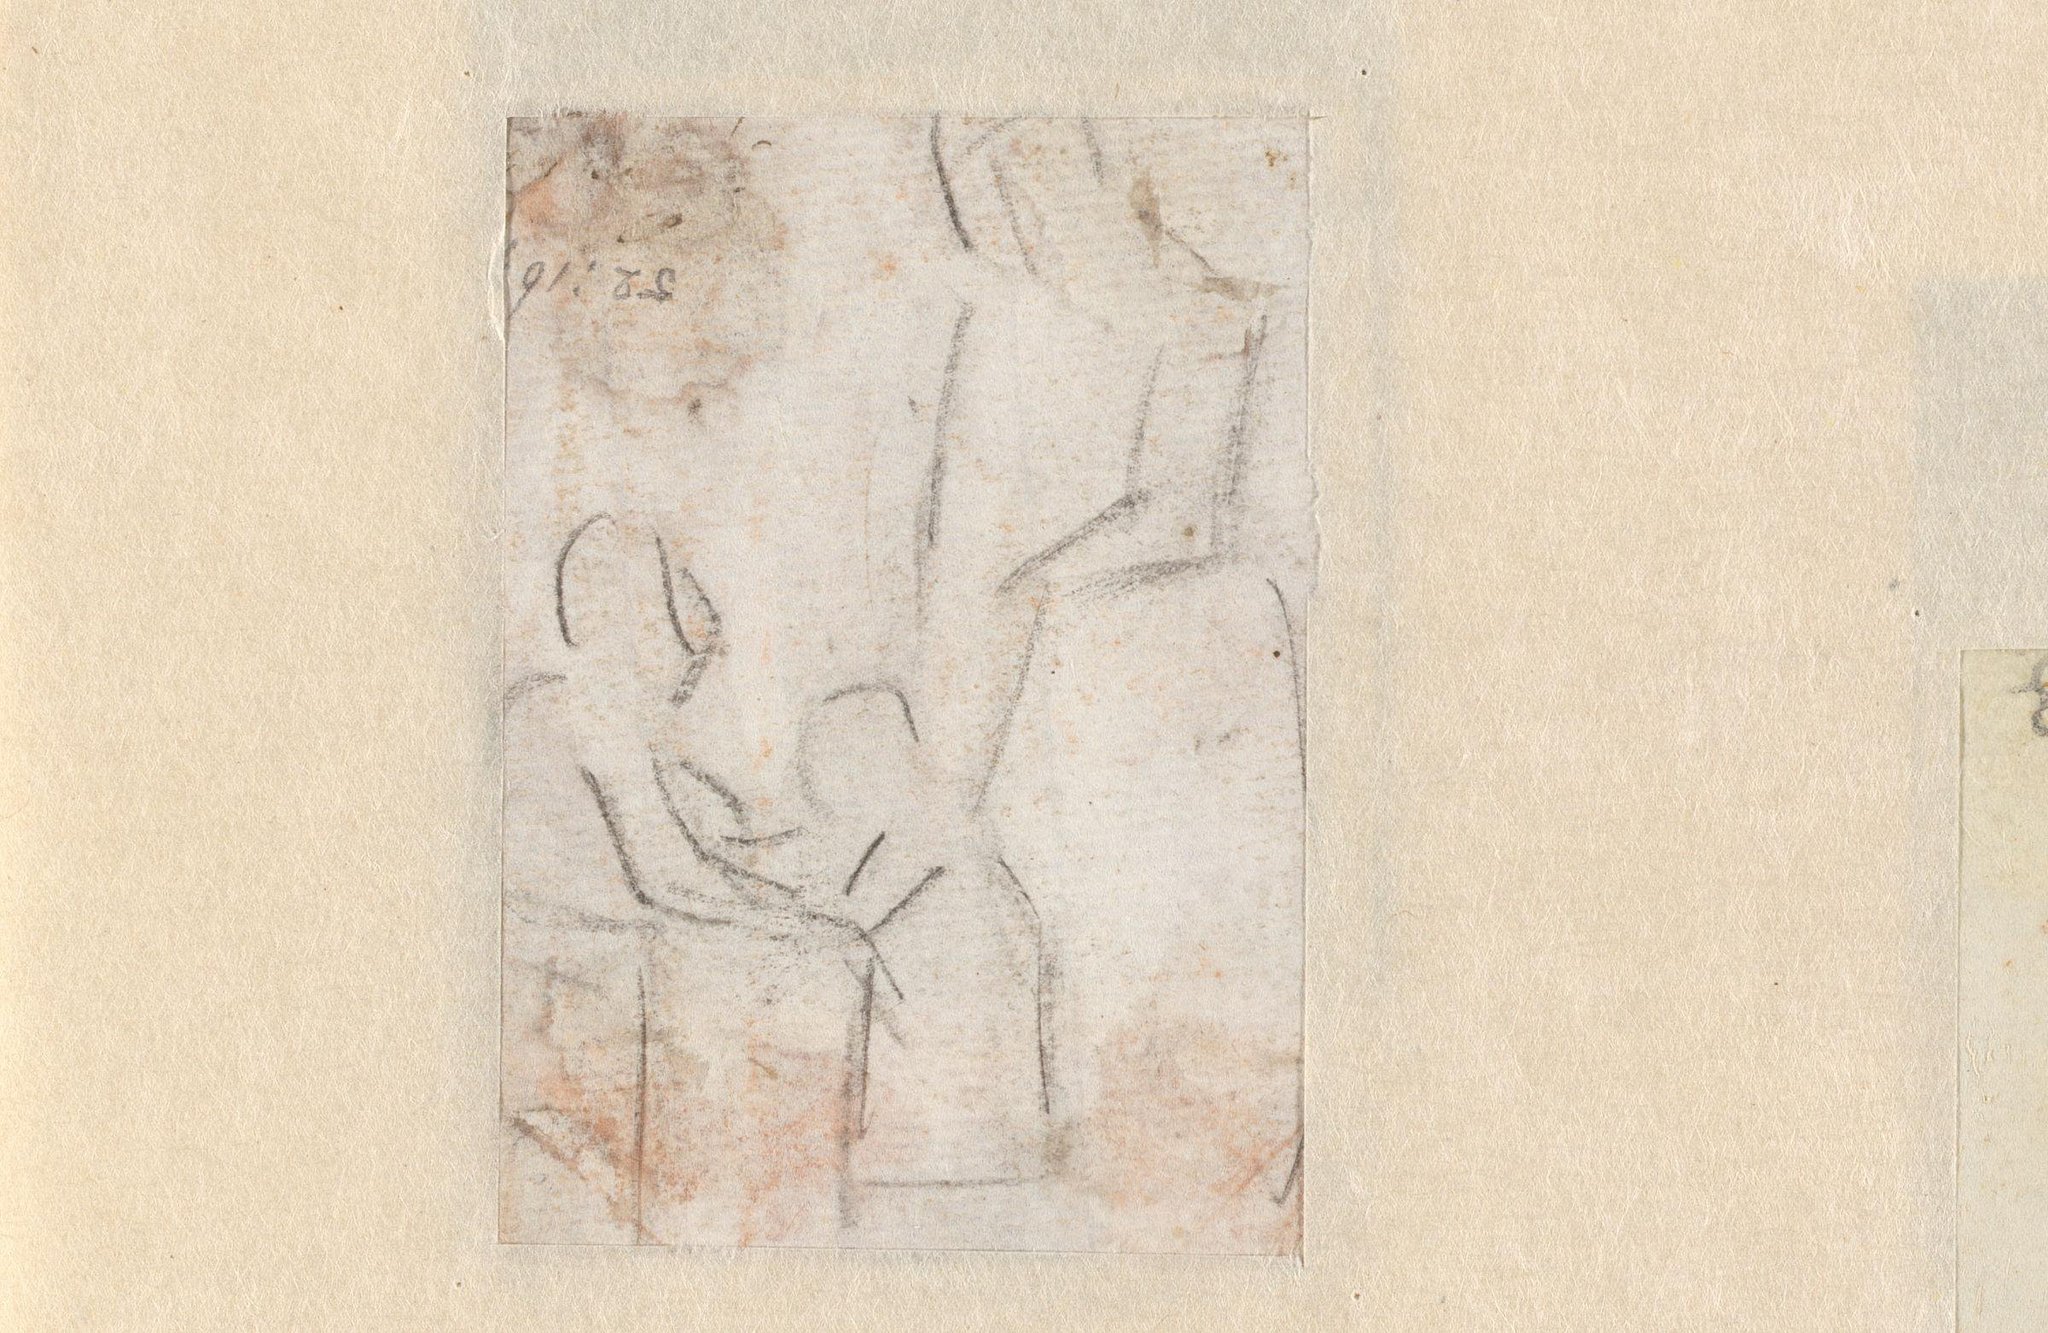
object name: drawing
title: Schets van een vrouw met twee kinderen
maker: simon andreas krausz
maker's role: draughtsman, print maker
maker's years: 1760-1825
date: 1770-1825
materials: chalk, paper